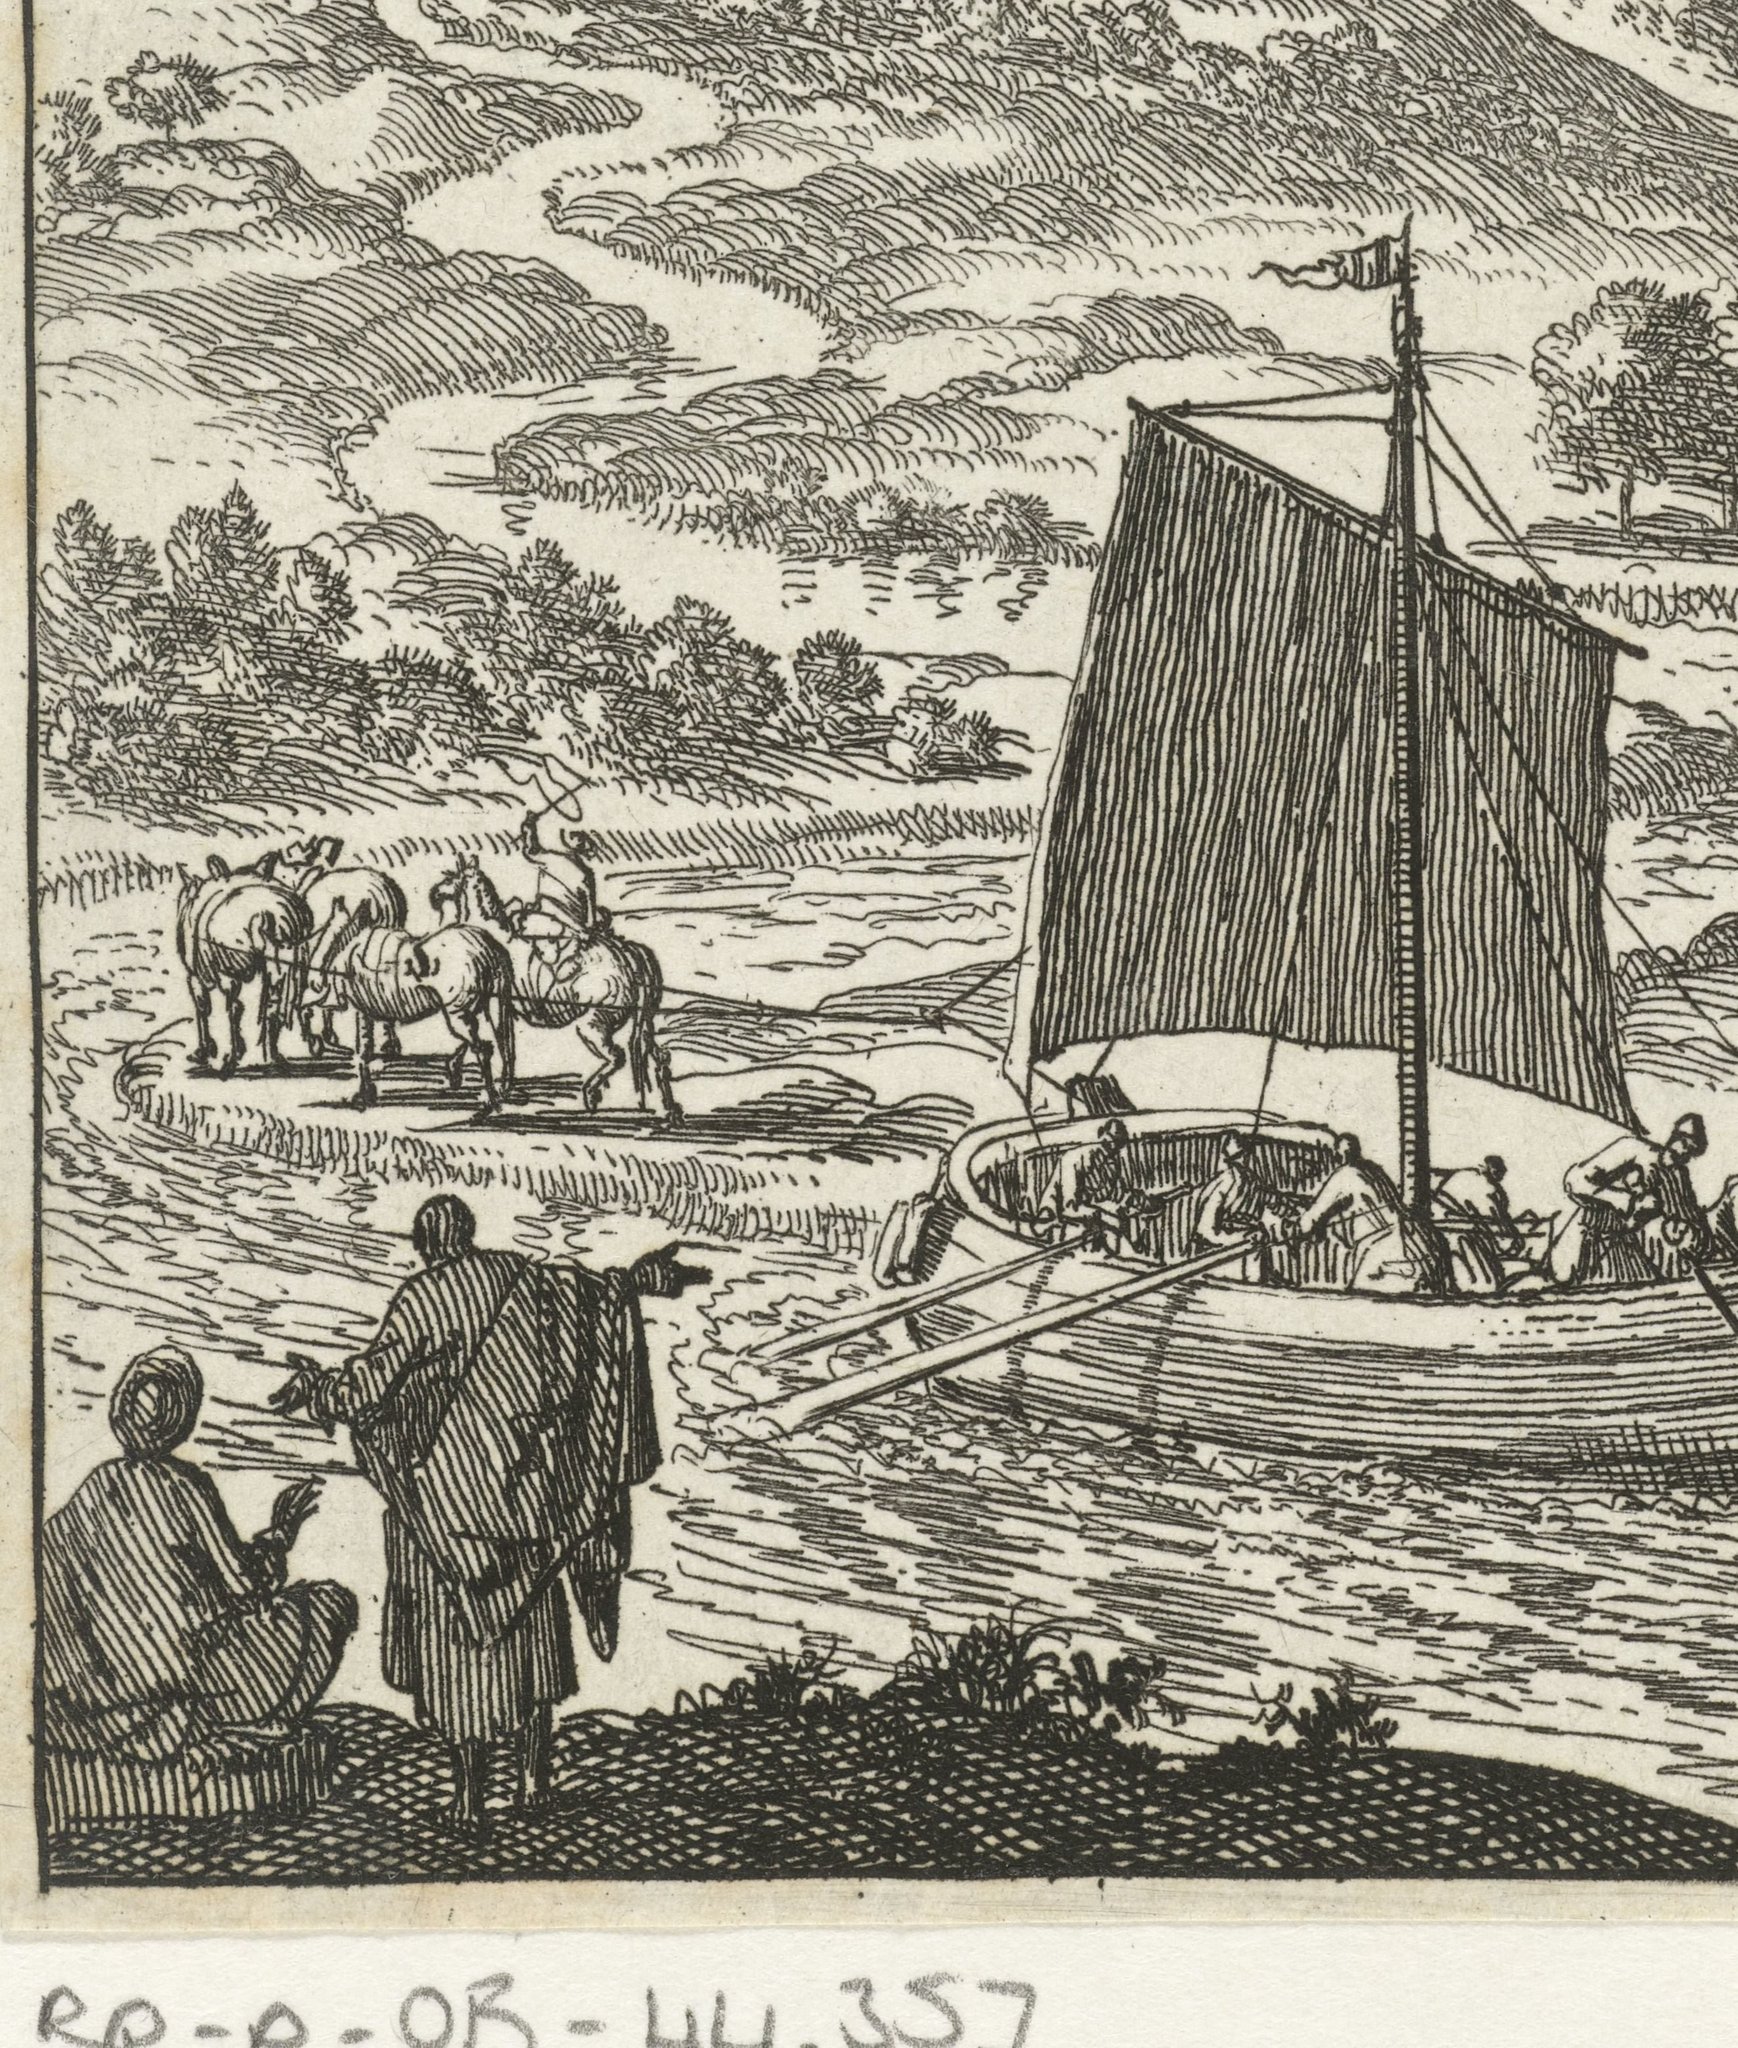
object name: print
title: Rivierlandschap waarin een schuit door vier paarden wordt voortgetrokken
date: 1689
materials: paper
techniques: etching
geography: amsterdam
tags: river, boat propelled by man or animal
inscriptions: collector's mark: Lugt 2228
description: Illustratie uit: Huygen, Pieter. De beginselen van Gods koninkryk in den mensch uitgedrukt in zinnebeelden. Amsterdam: wed. Arentsz. Pieter (II), 1689, p. 74.